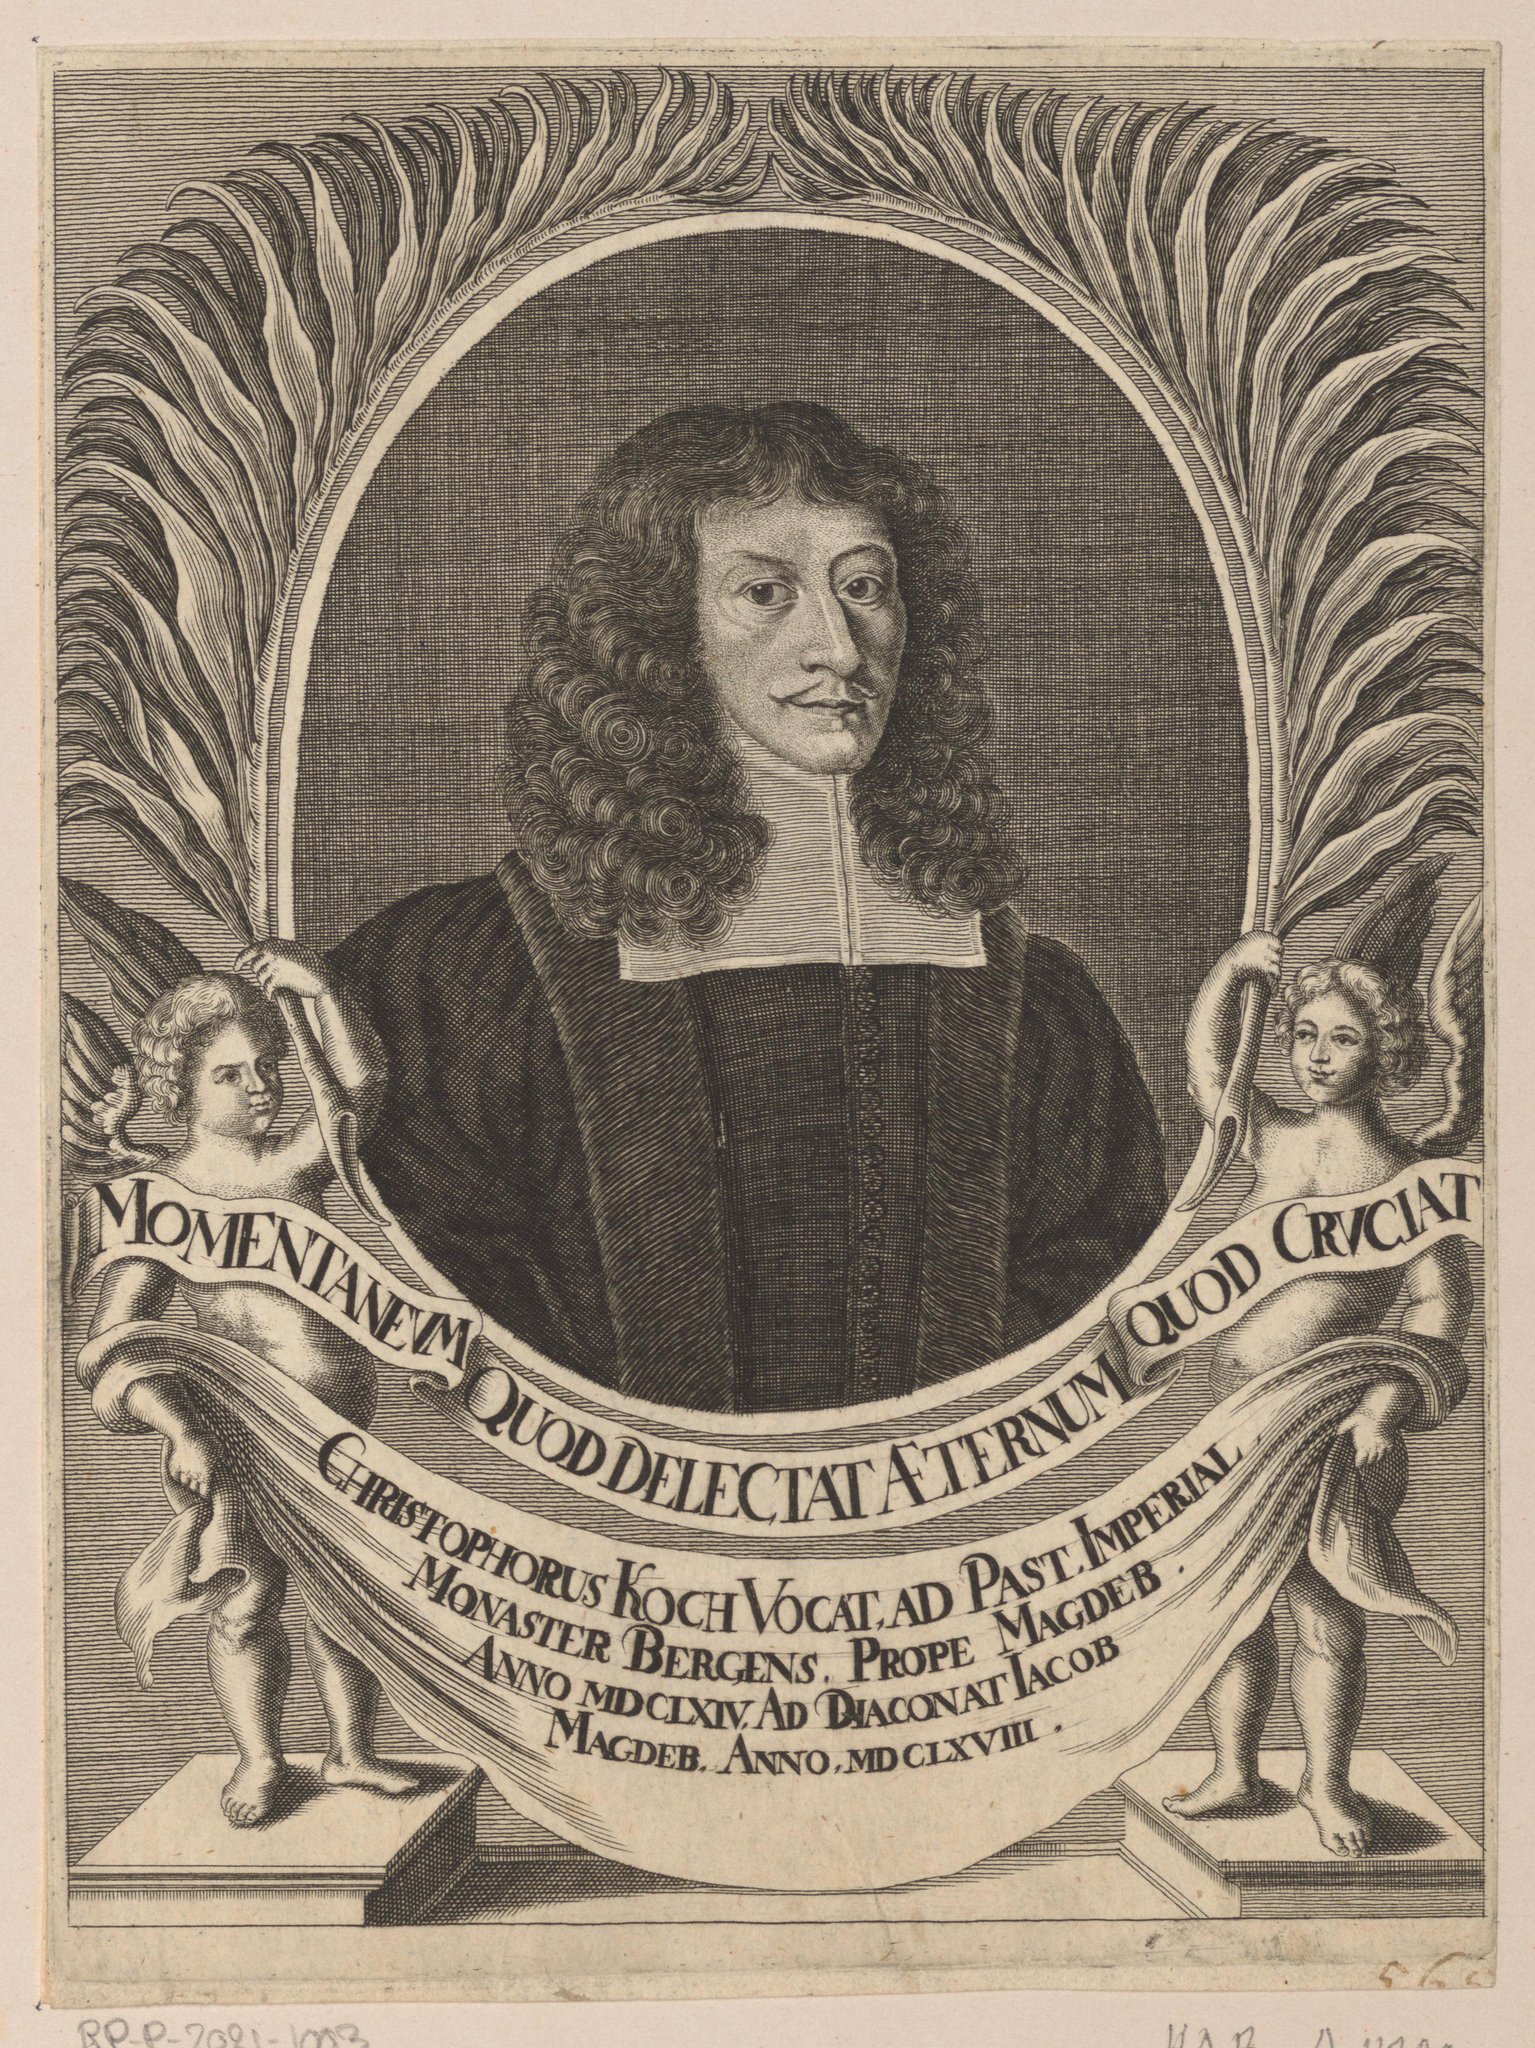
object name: print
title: Portret van Christoph Koch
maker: christian romstet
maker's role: print maker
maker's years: 1640-1721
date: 1668-1721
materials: paper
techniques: engraving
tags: historical persons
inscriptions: watermark